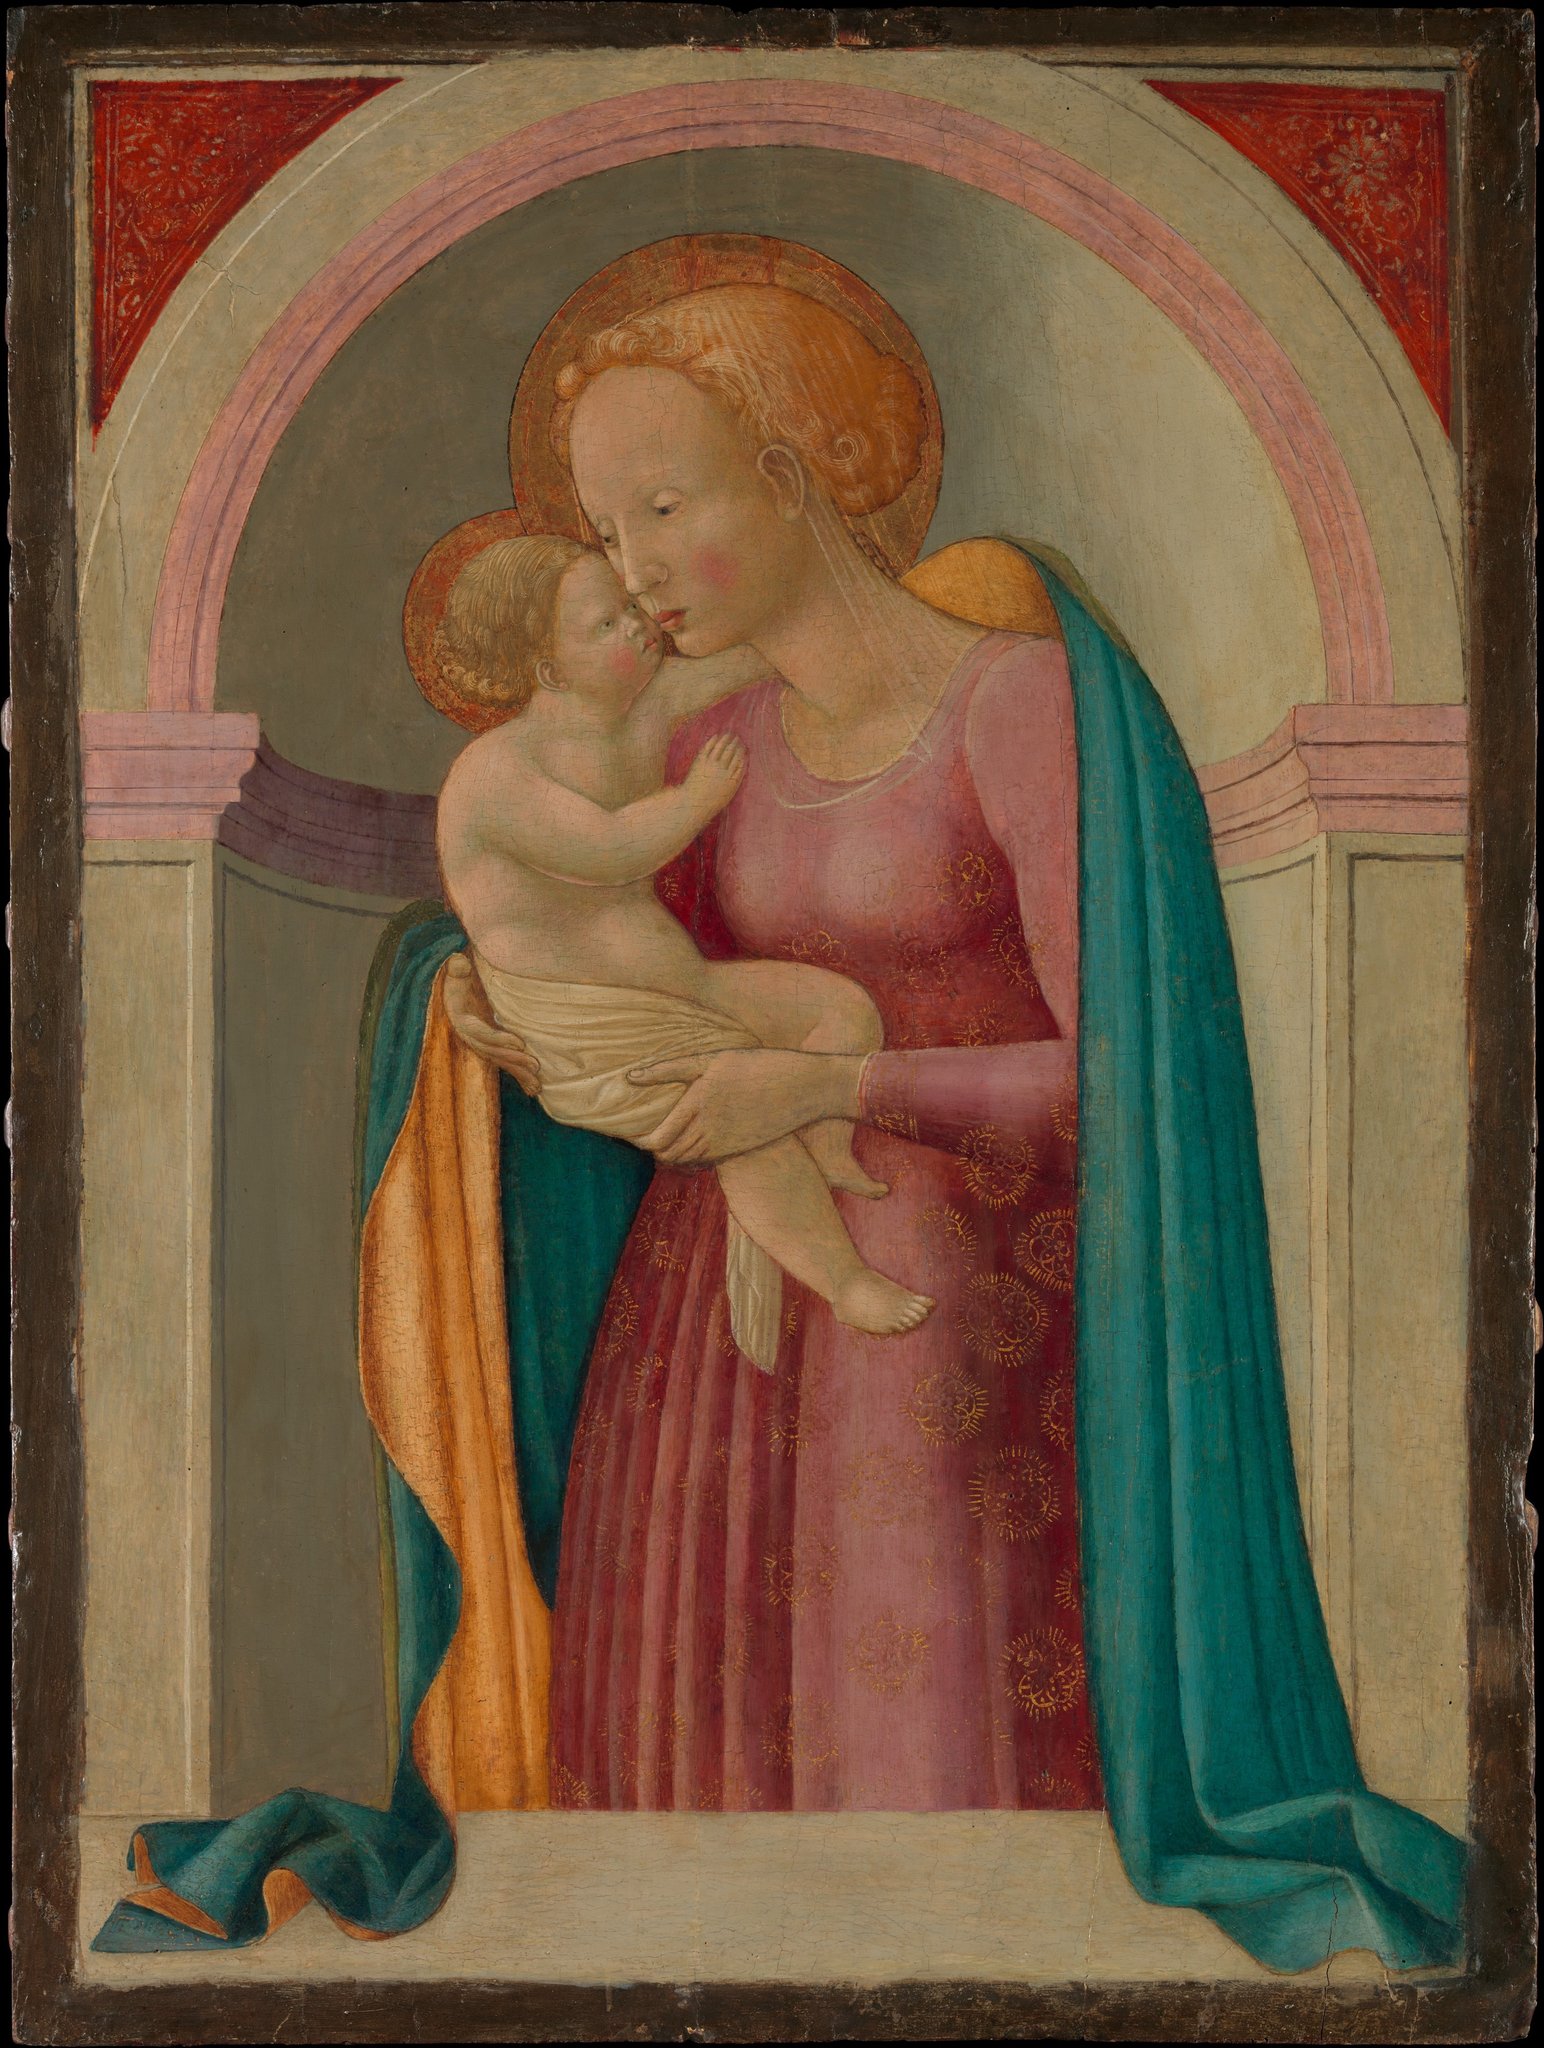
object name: painting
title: Madonna and Child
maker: master of the lanckoronski annunciation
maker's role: artist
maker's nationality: italian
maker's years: 1425-1449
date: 1425-1449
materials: gold, paint, wood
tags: madonna and child